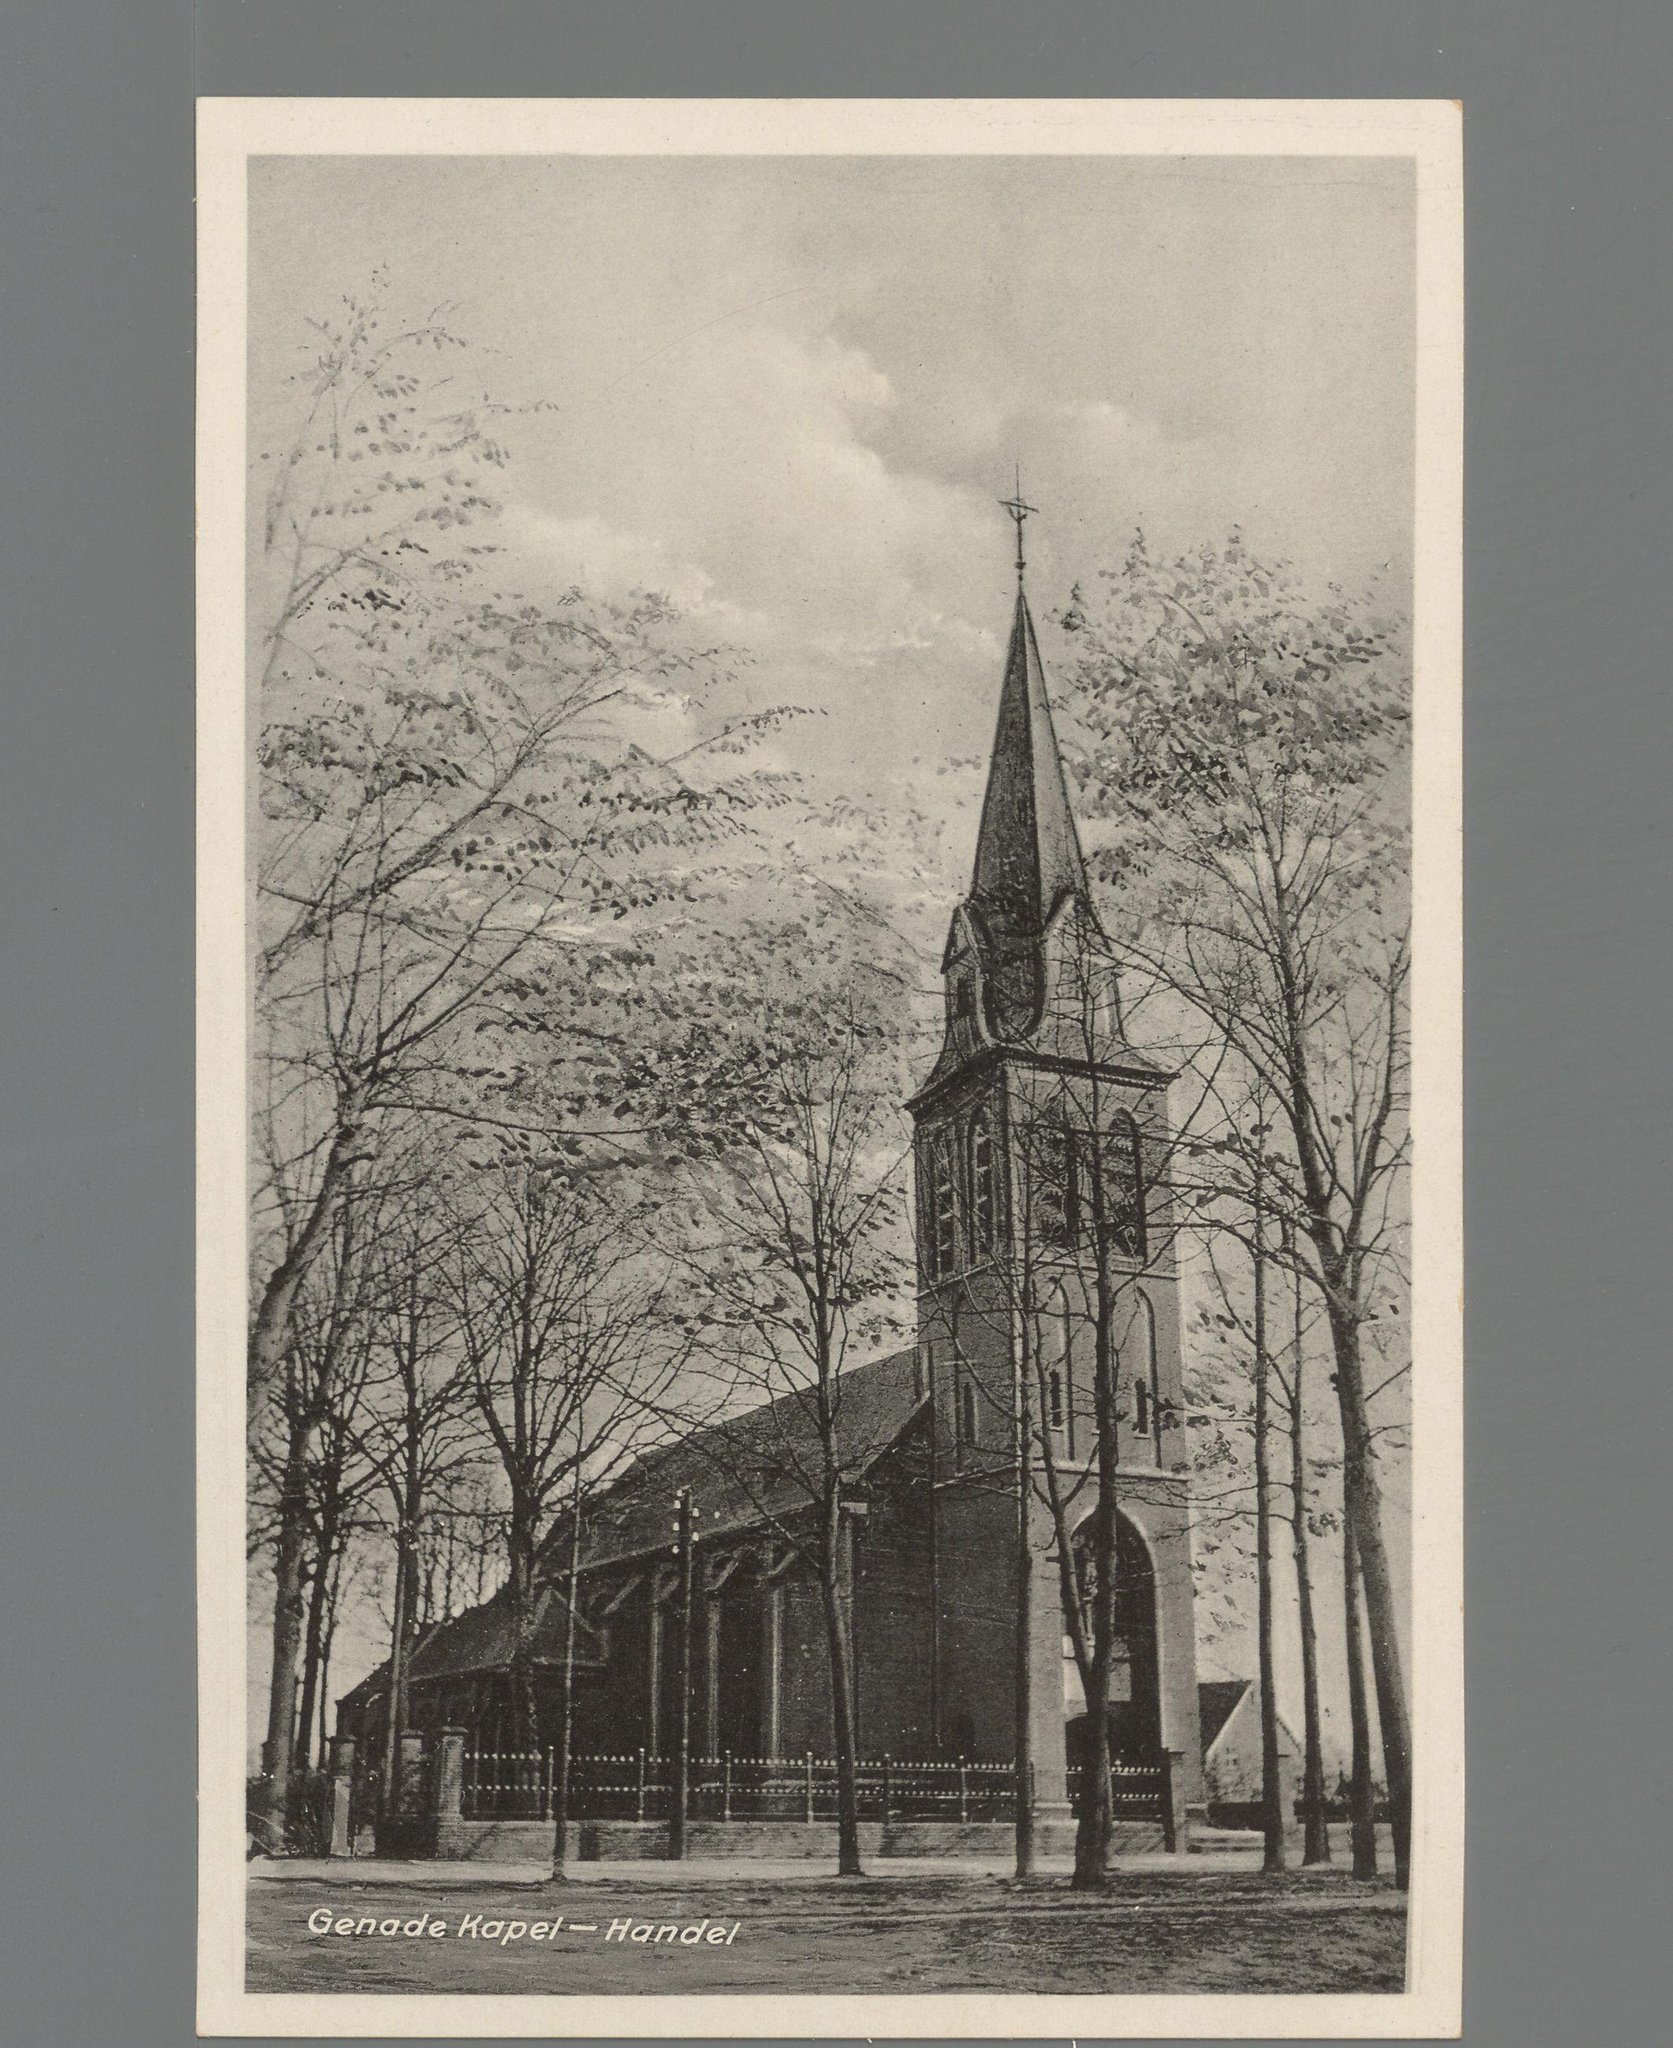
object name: photomechanical print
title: Genade Kapel - Handel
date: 1913-1950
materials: cardboard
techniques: photograph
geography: handel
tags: church (exterior)